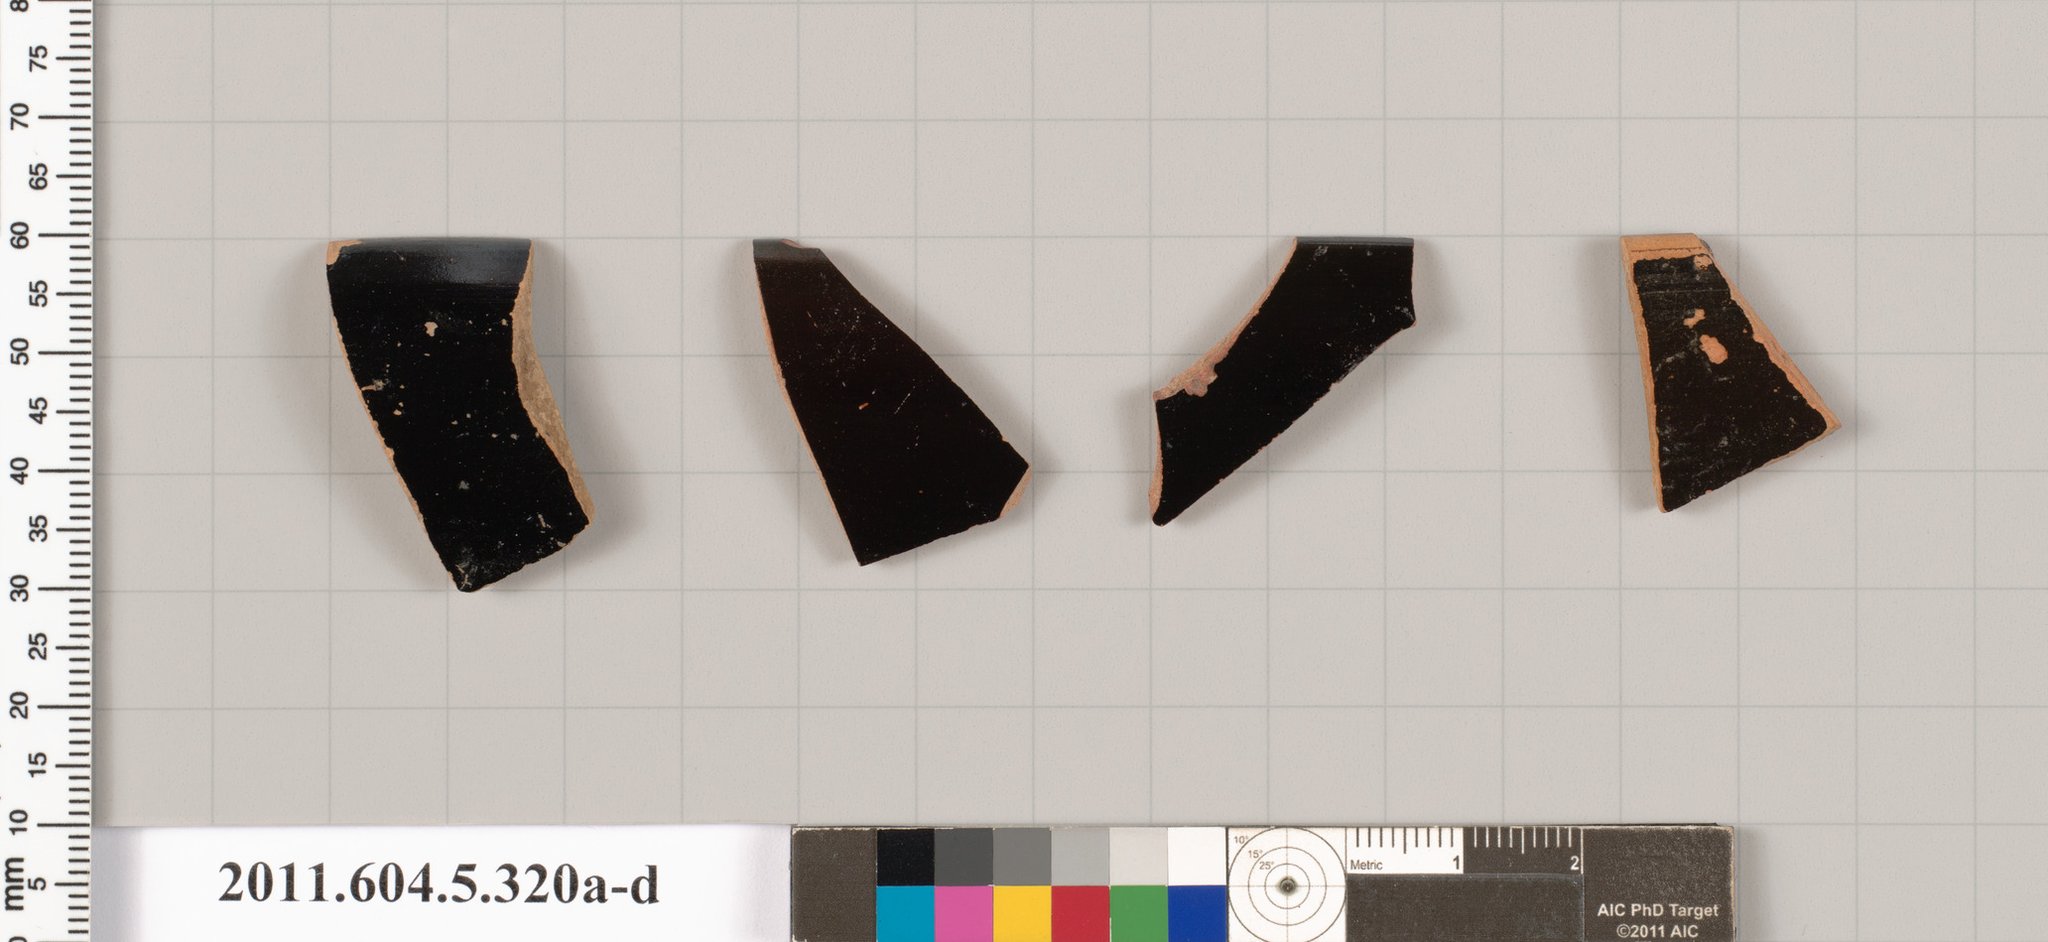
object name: kylix fragment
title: Terracotta rim fragments of kylikes (drinking cups)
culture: greek, attic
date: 600-401 BCE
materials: terracotta